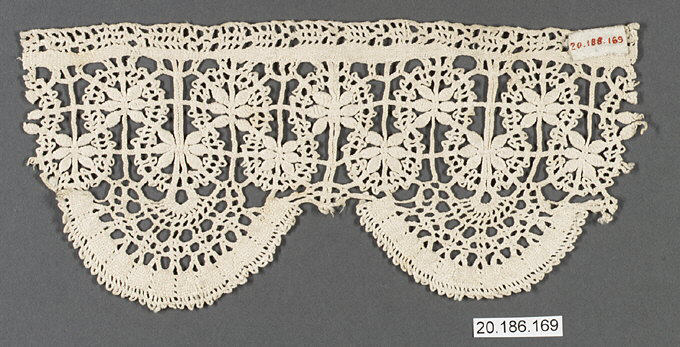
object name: edging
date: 1601-1700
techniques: lace